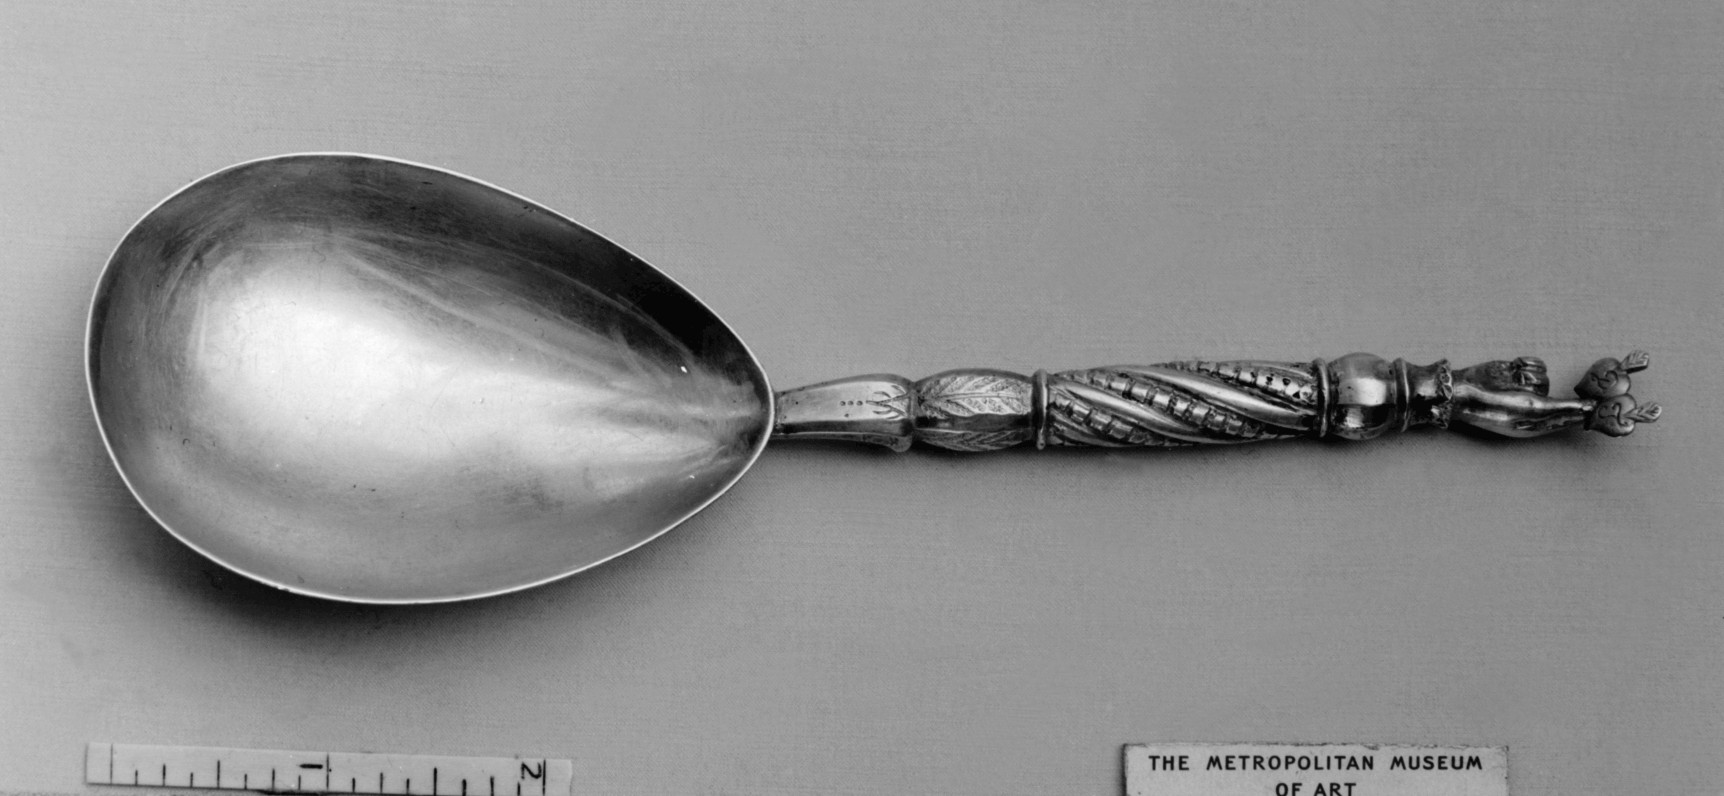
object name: spoon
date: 1701-1800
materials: gilt, silver